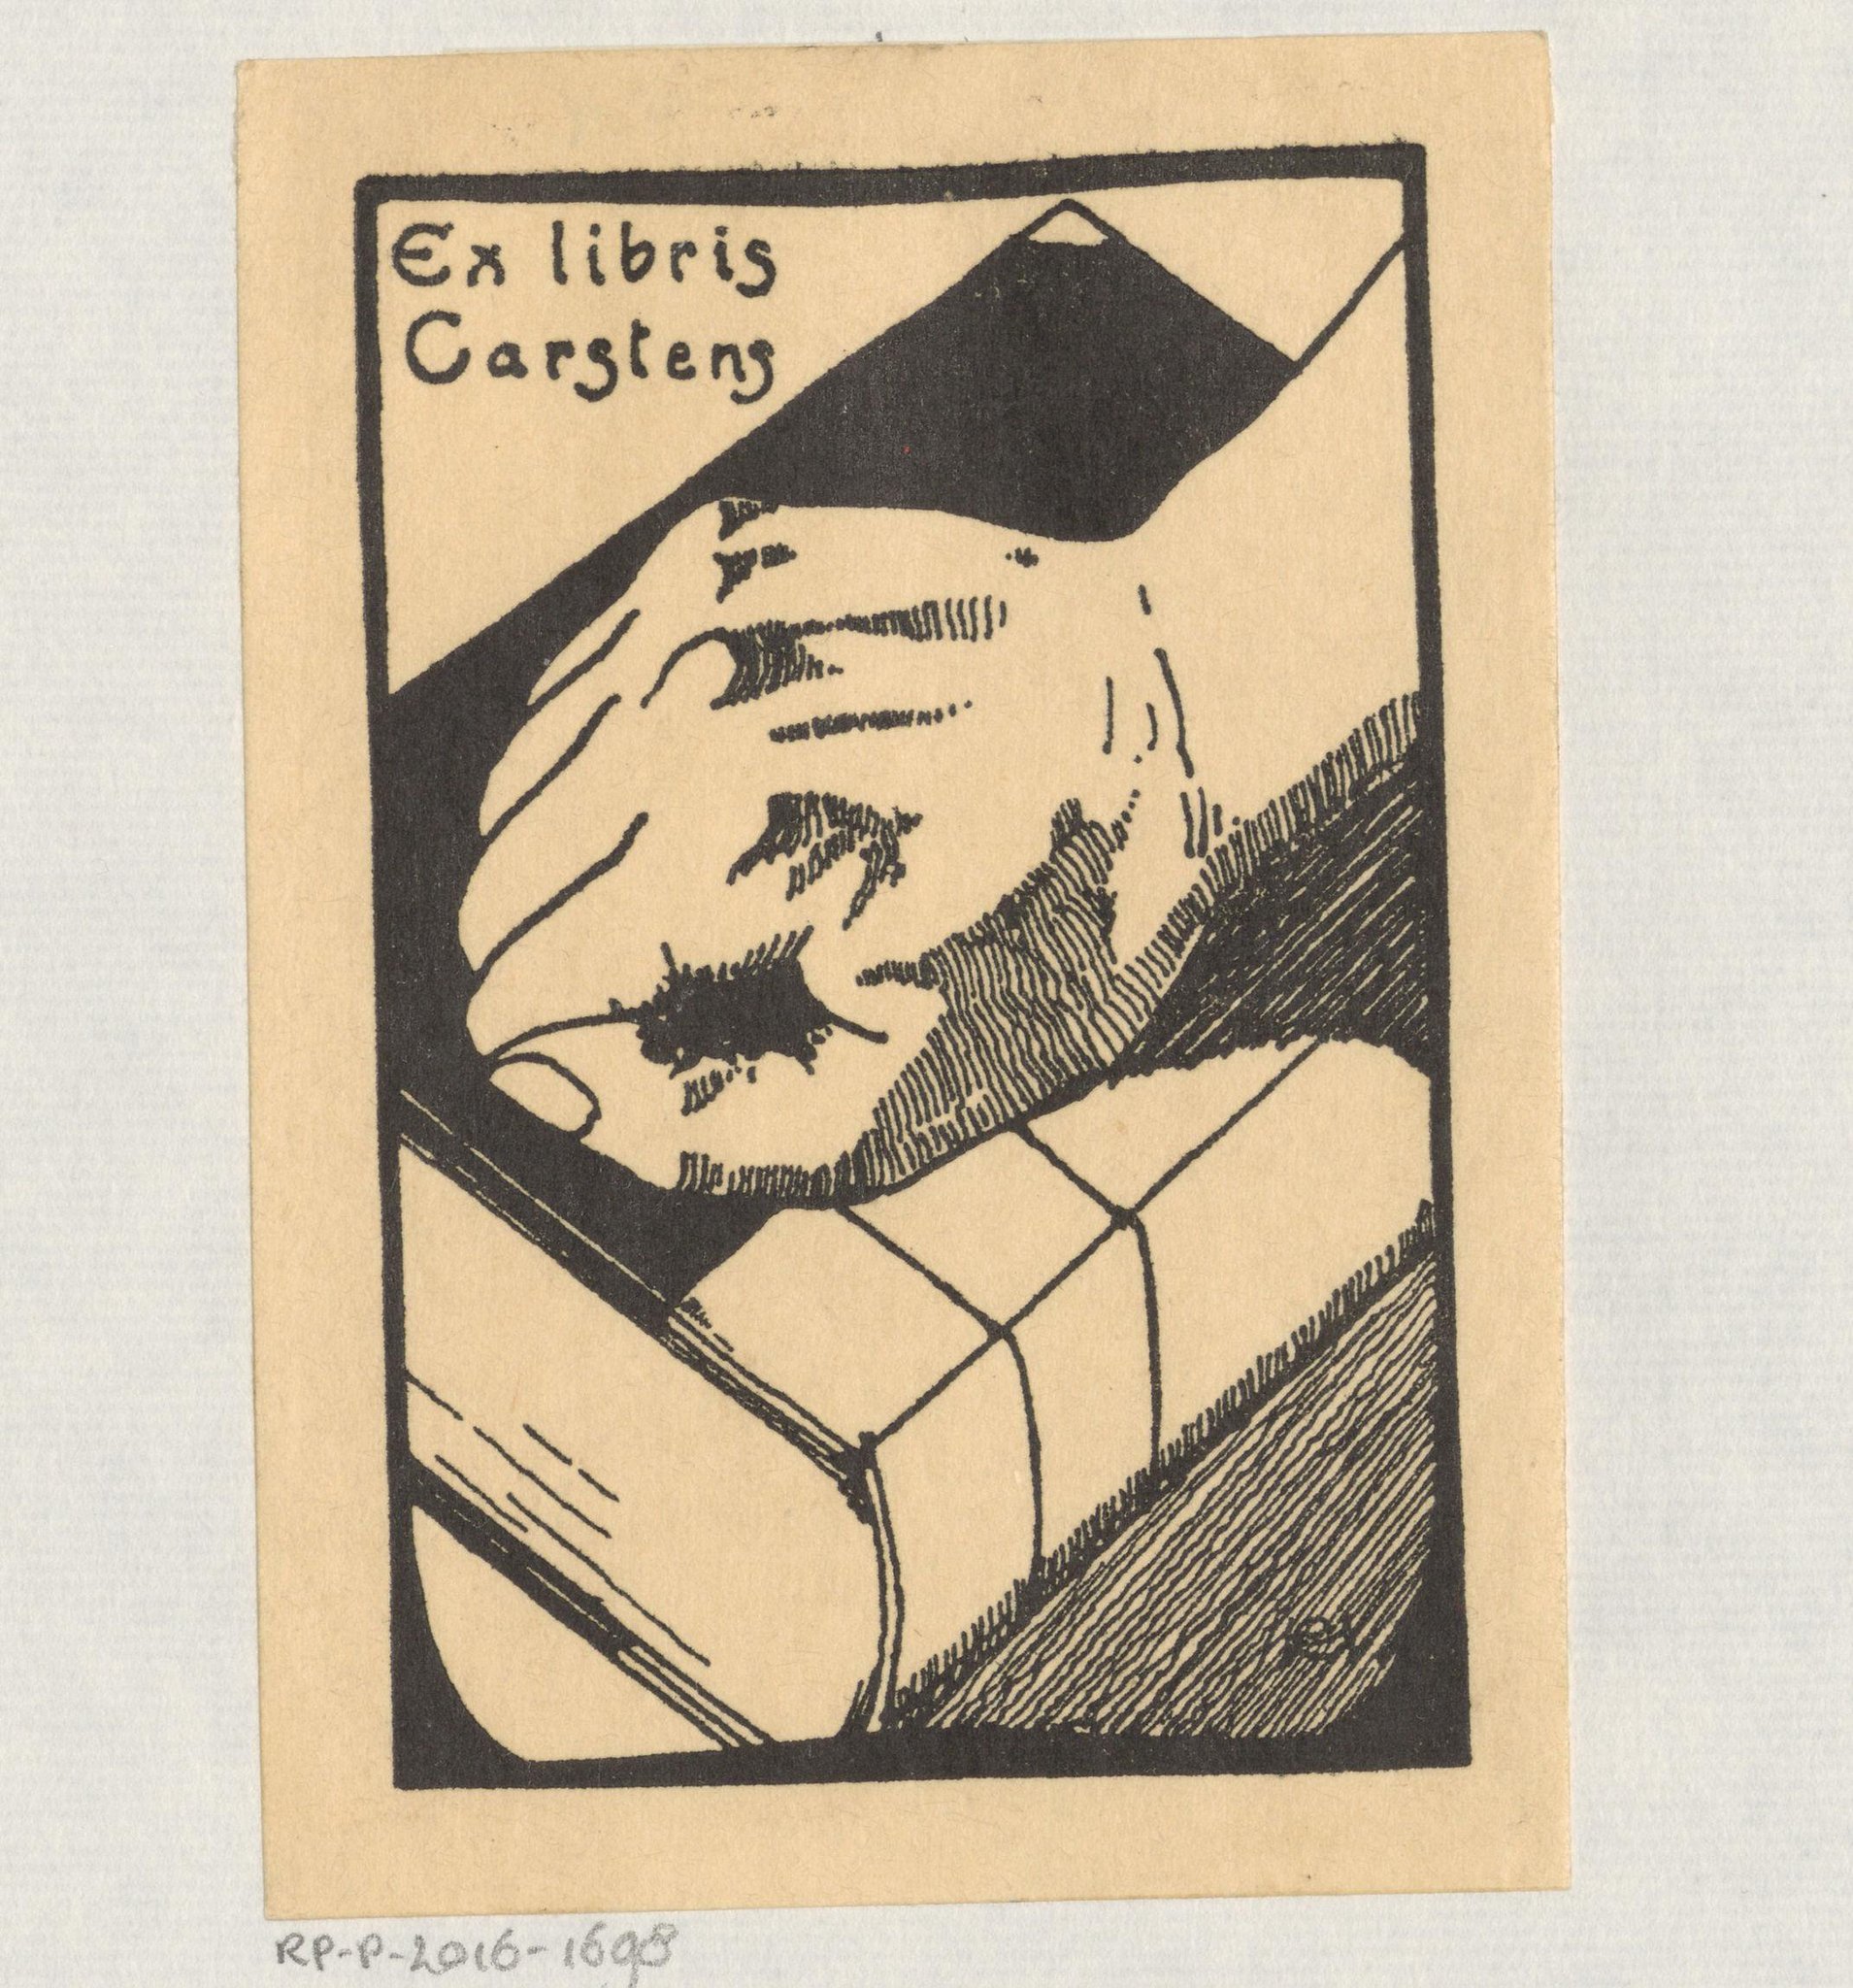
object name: bookplate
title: Ex libris van Carstens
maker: Anonymous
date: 1900-1999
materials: paper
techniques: printing block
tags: single printed leaf: broadsheet, leaflet